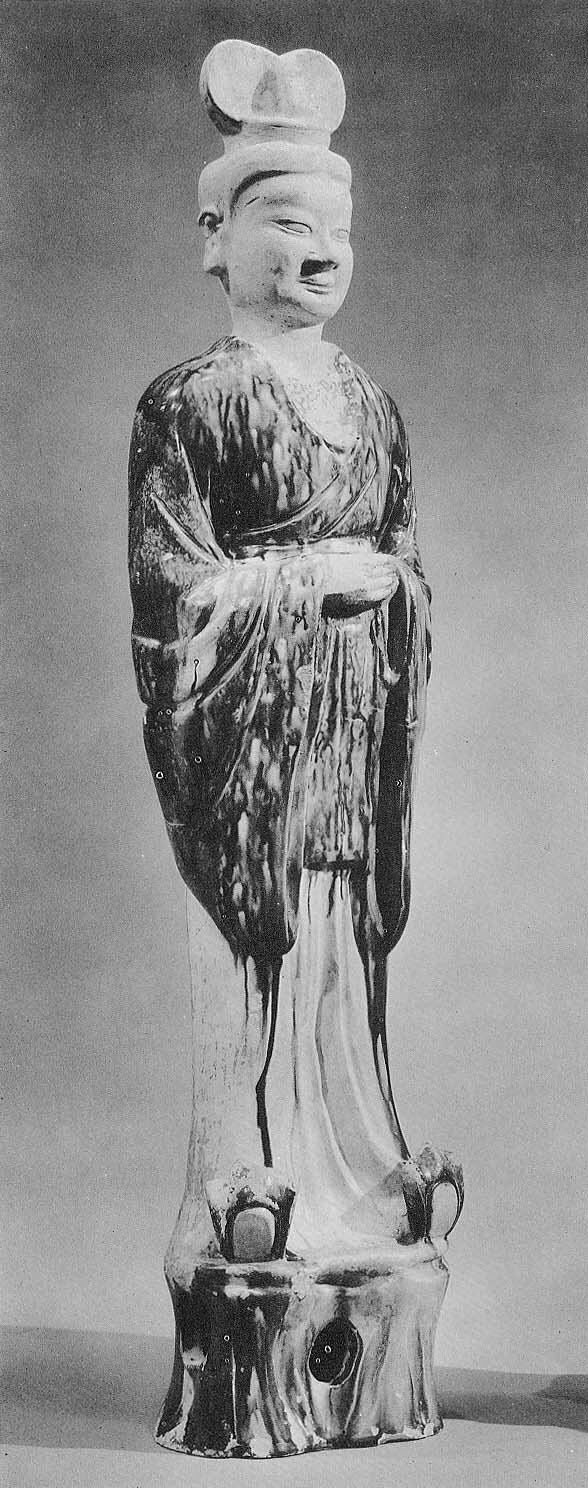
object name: figure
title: Civil official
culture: chinese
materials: earthenware, glaze, pigment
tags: dresses,hats,men